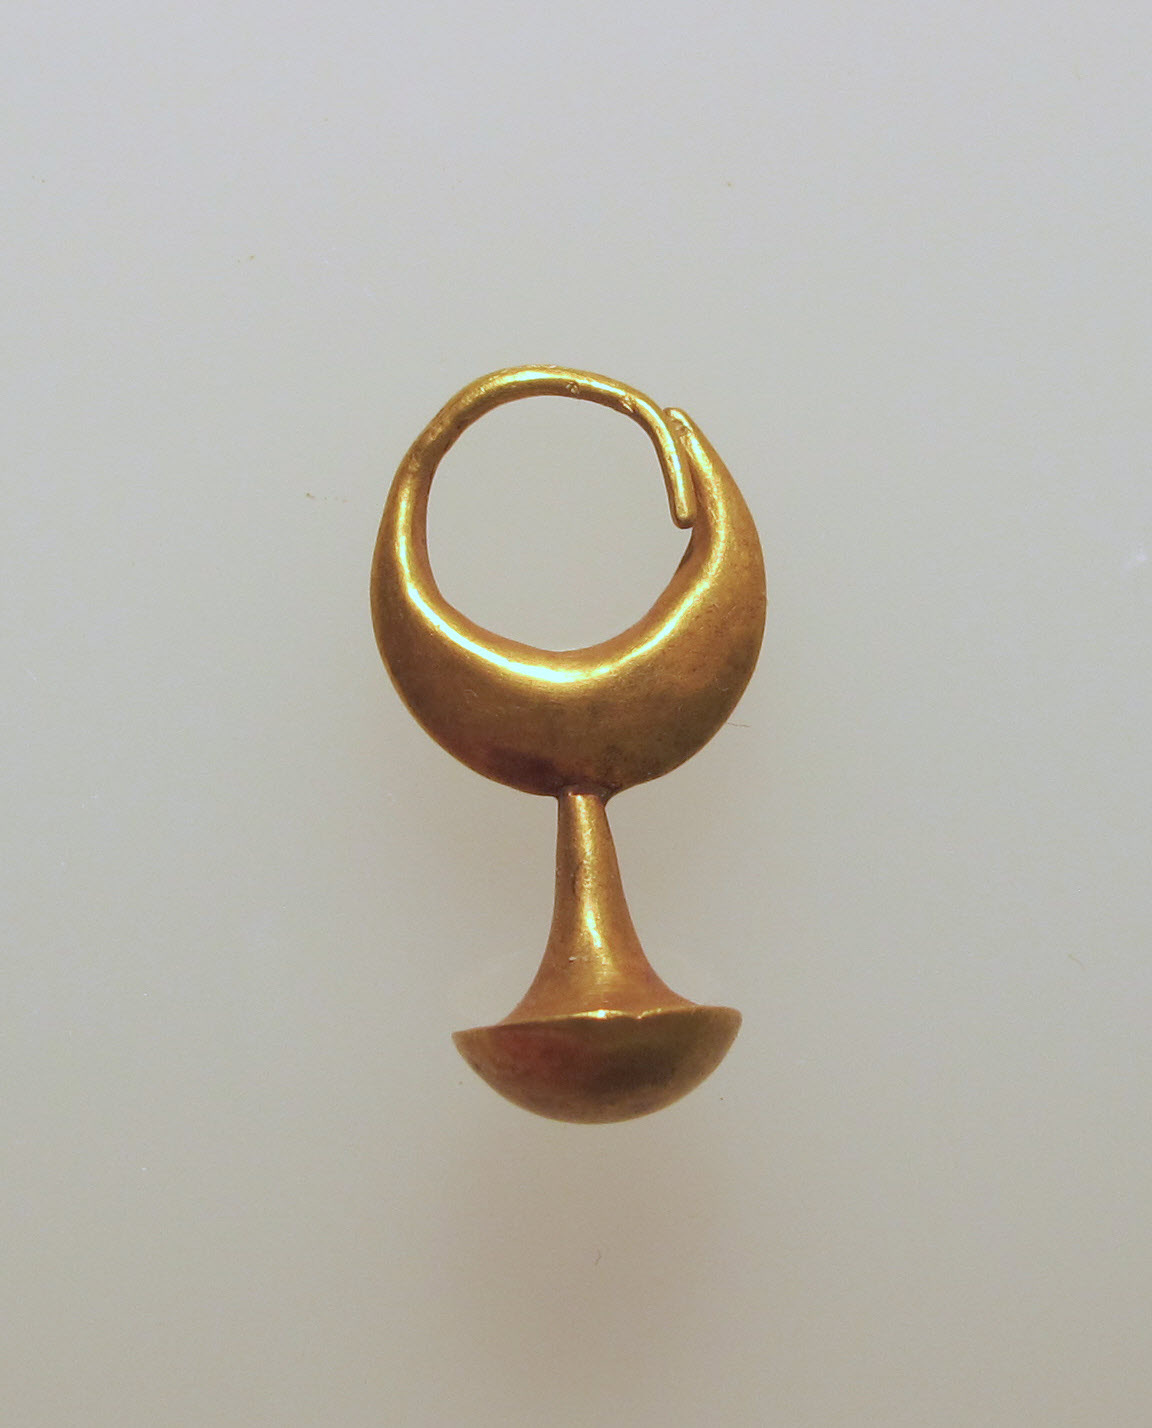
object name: earring with nail head pendant, 12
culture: cypriot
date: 3900 BCE-100 CE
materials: gold